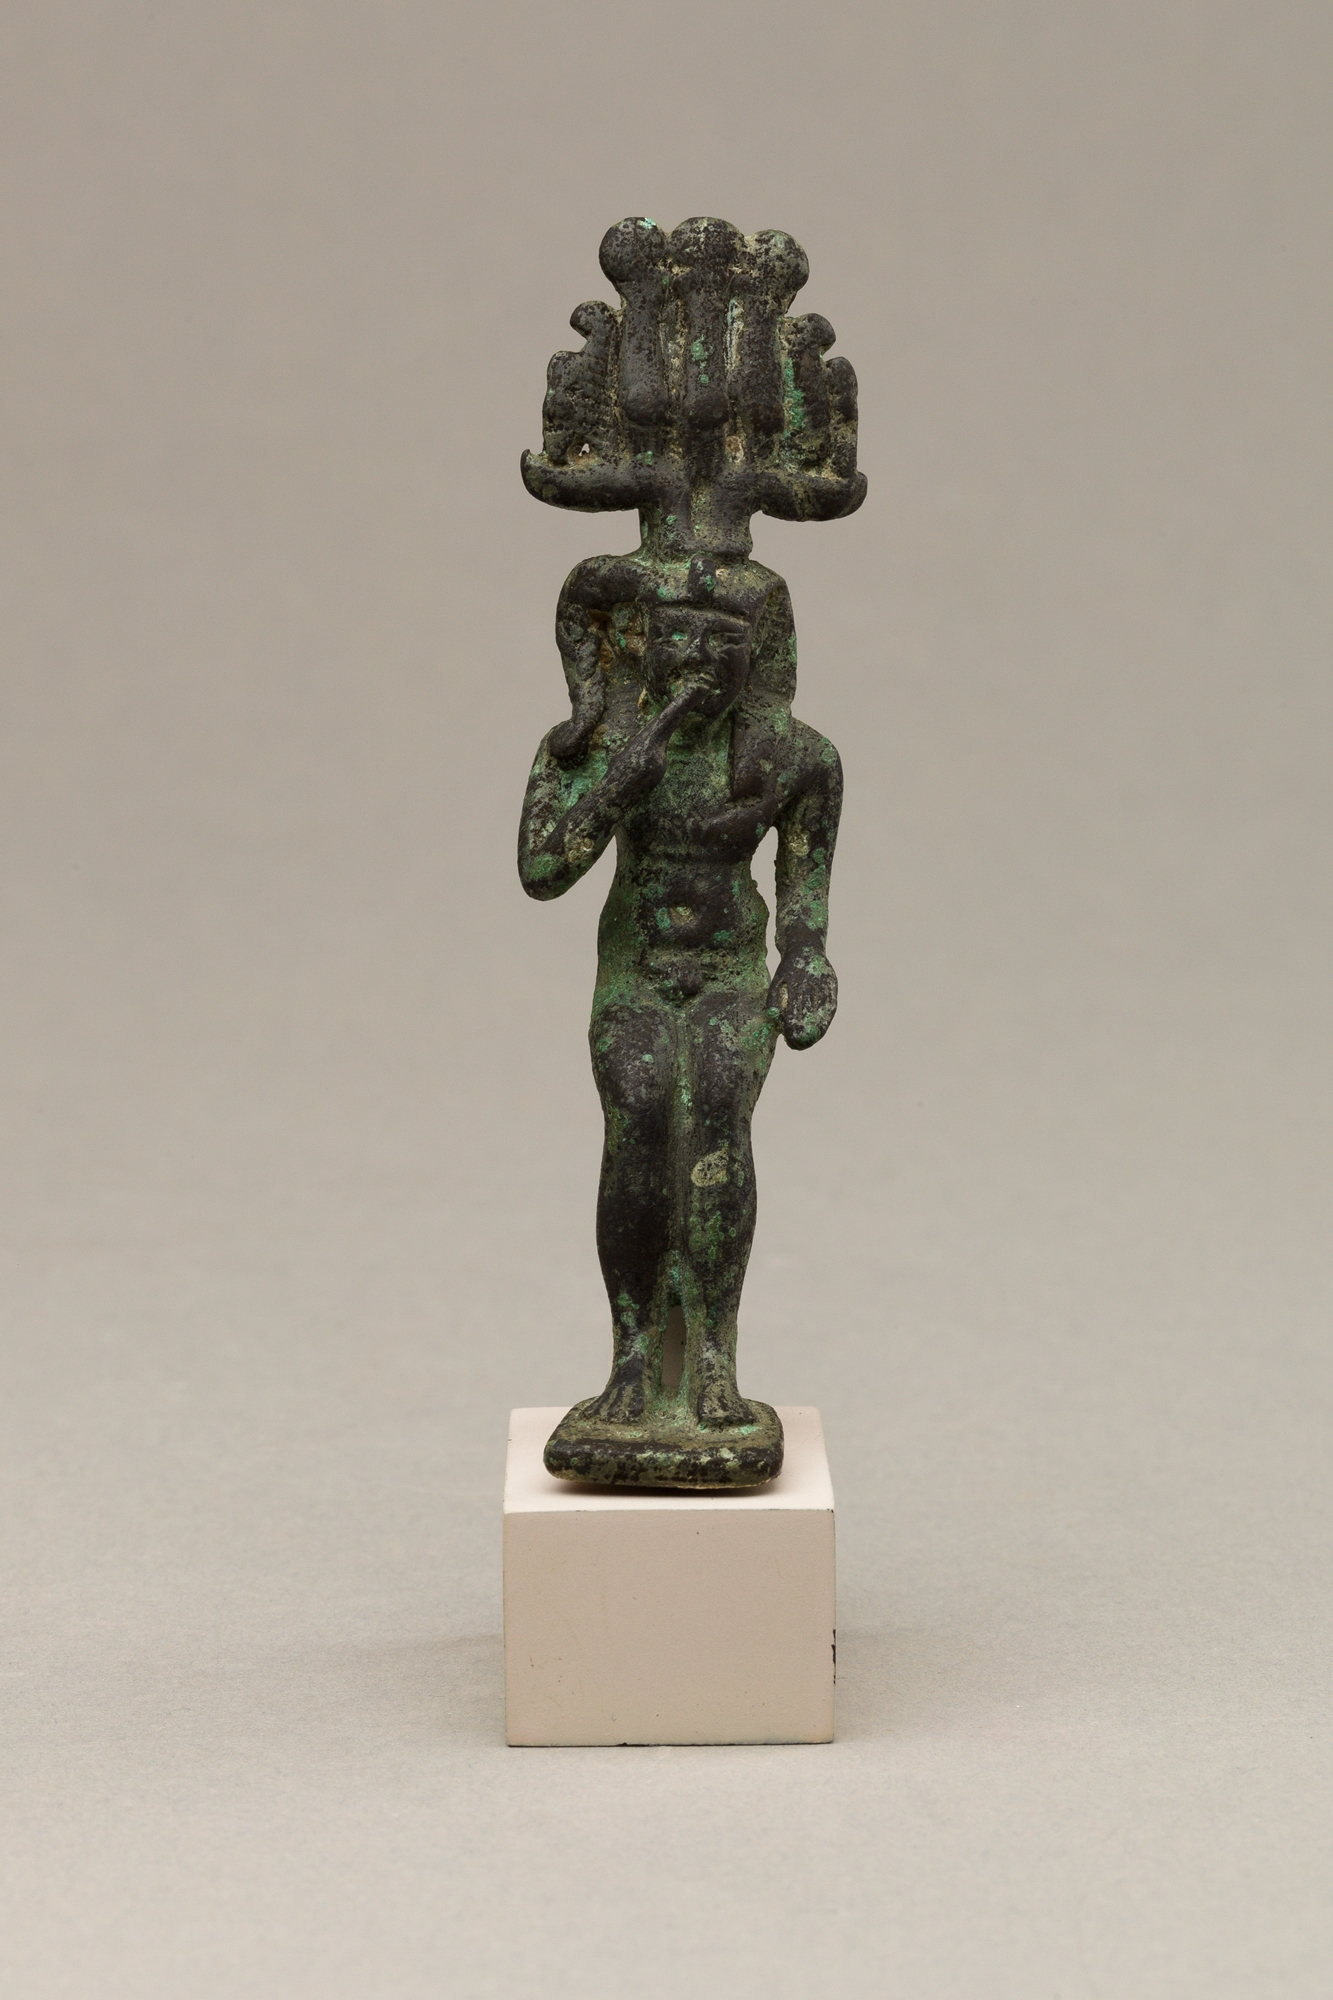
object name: statuette, child god, hemhem crown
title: Child god with hemhem crown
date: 664-630 BCE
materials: metal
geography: egypt